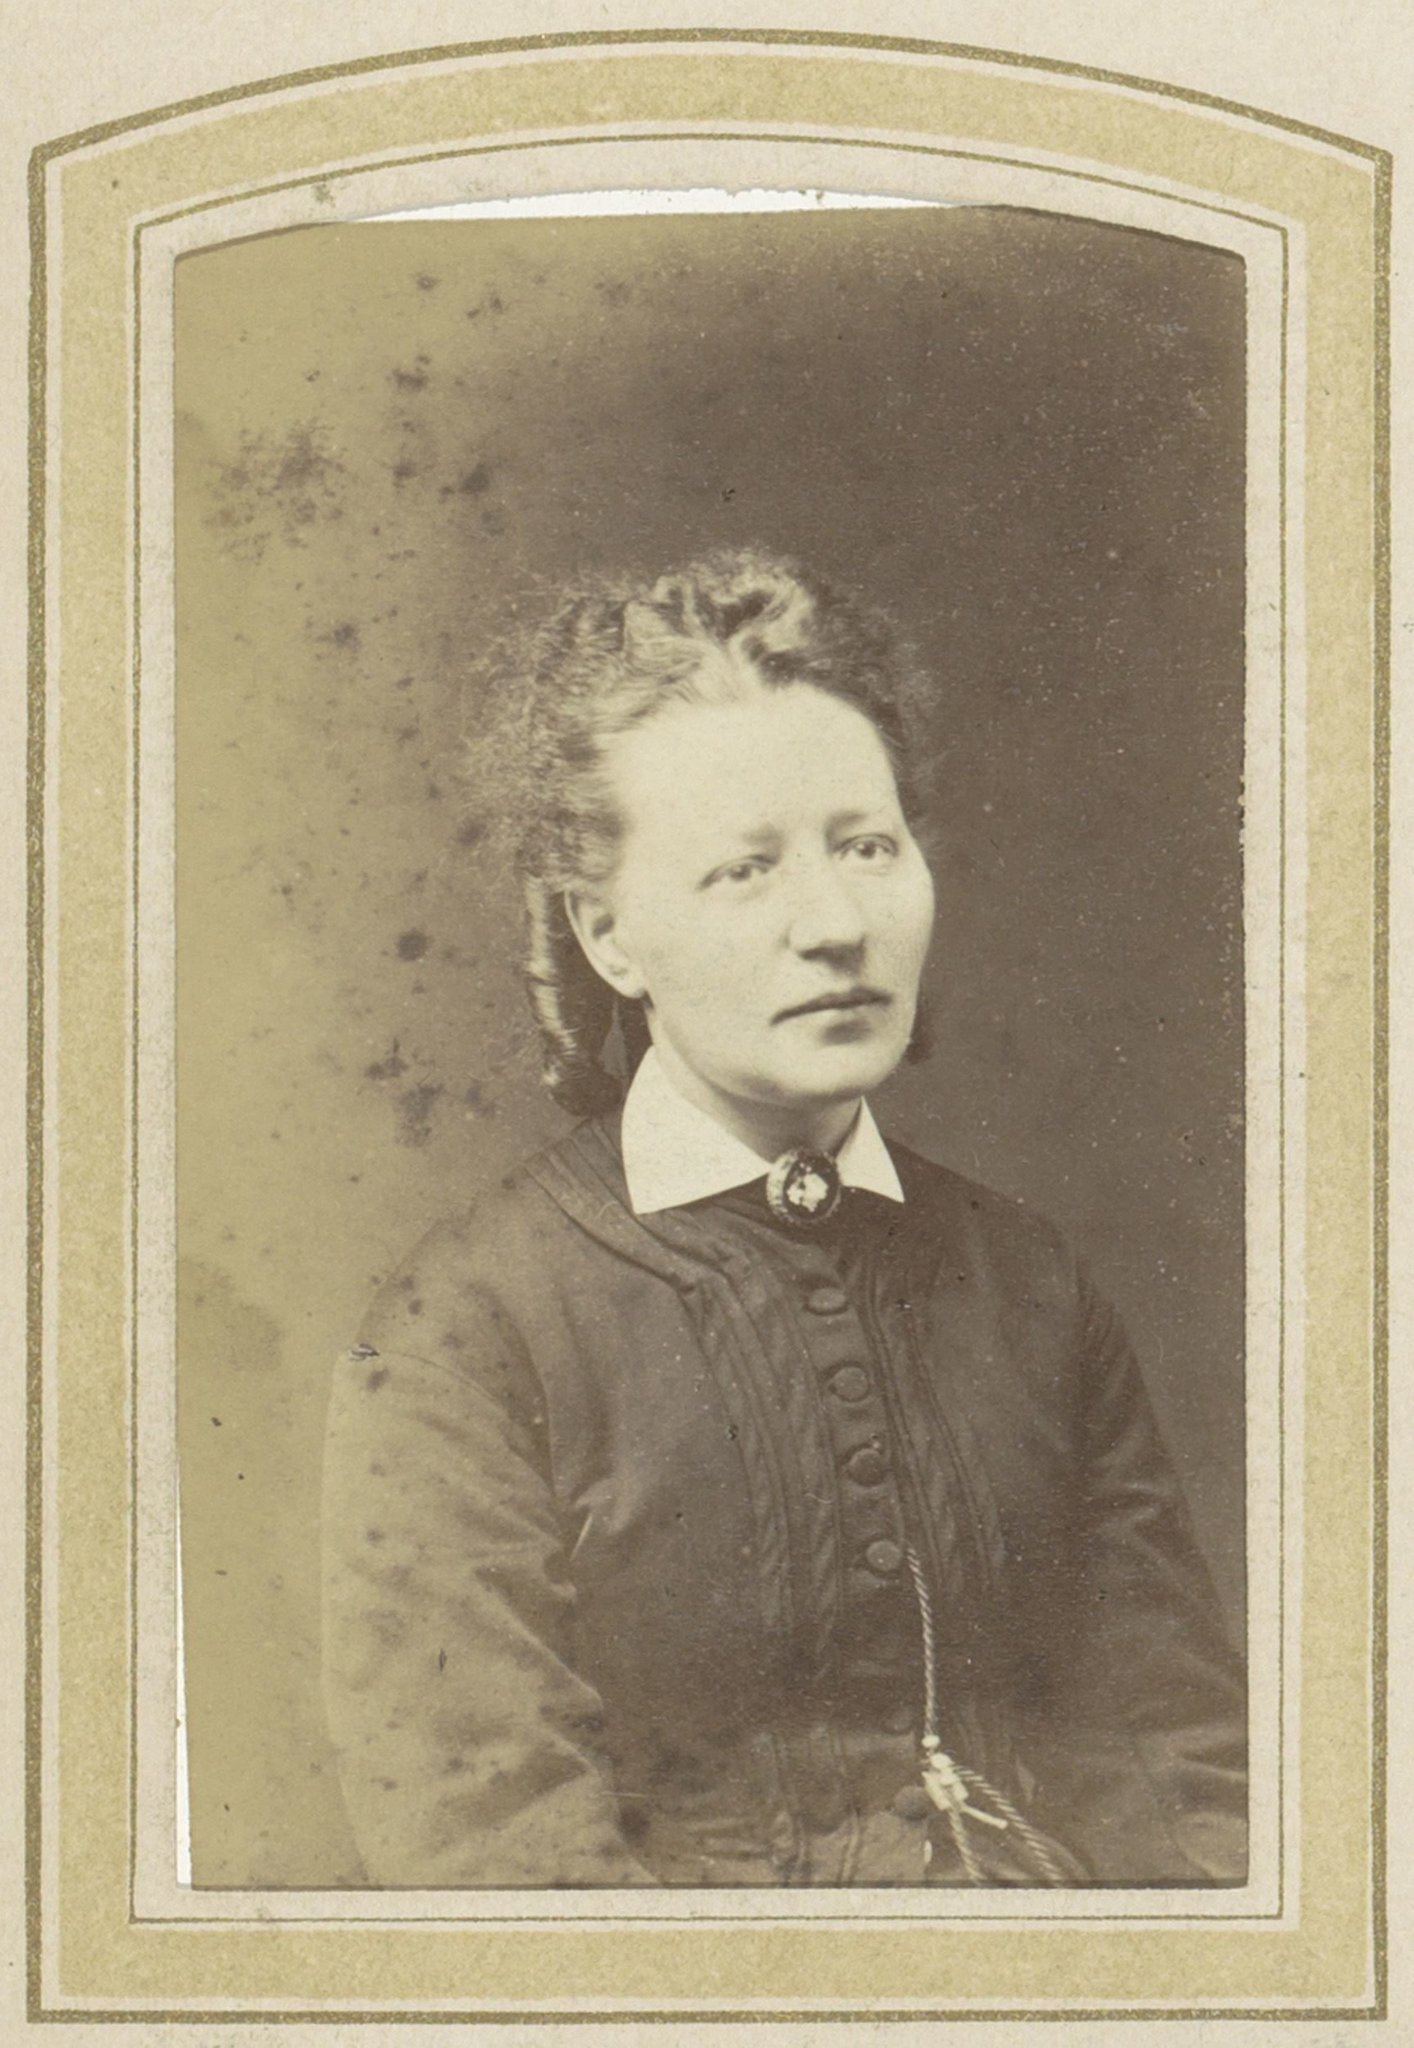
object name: photograph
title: Portret van een vrouw met een halssieraad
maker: Anonymous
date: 1860-1900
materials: cardboard, paper, photographic support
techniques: albumen print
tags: historical persons, styles of hairdress - aa - ~ women, clothing for the upper part of the body, brooch, agraffe, clasp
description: Onderdeel van Fotoalbum van een Nederlandse familie met 168 cartes-de-visite en kabinetfoto's.